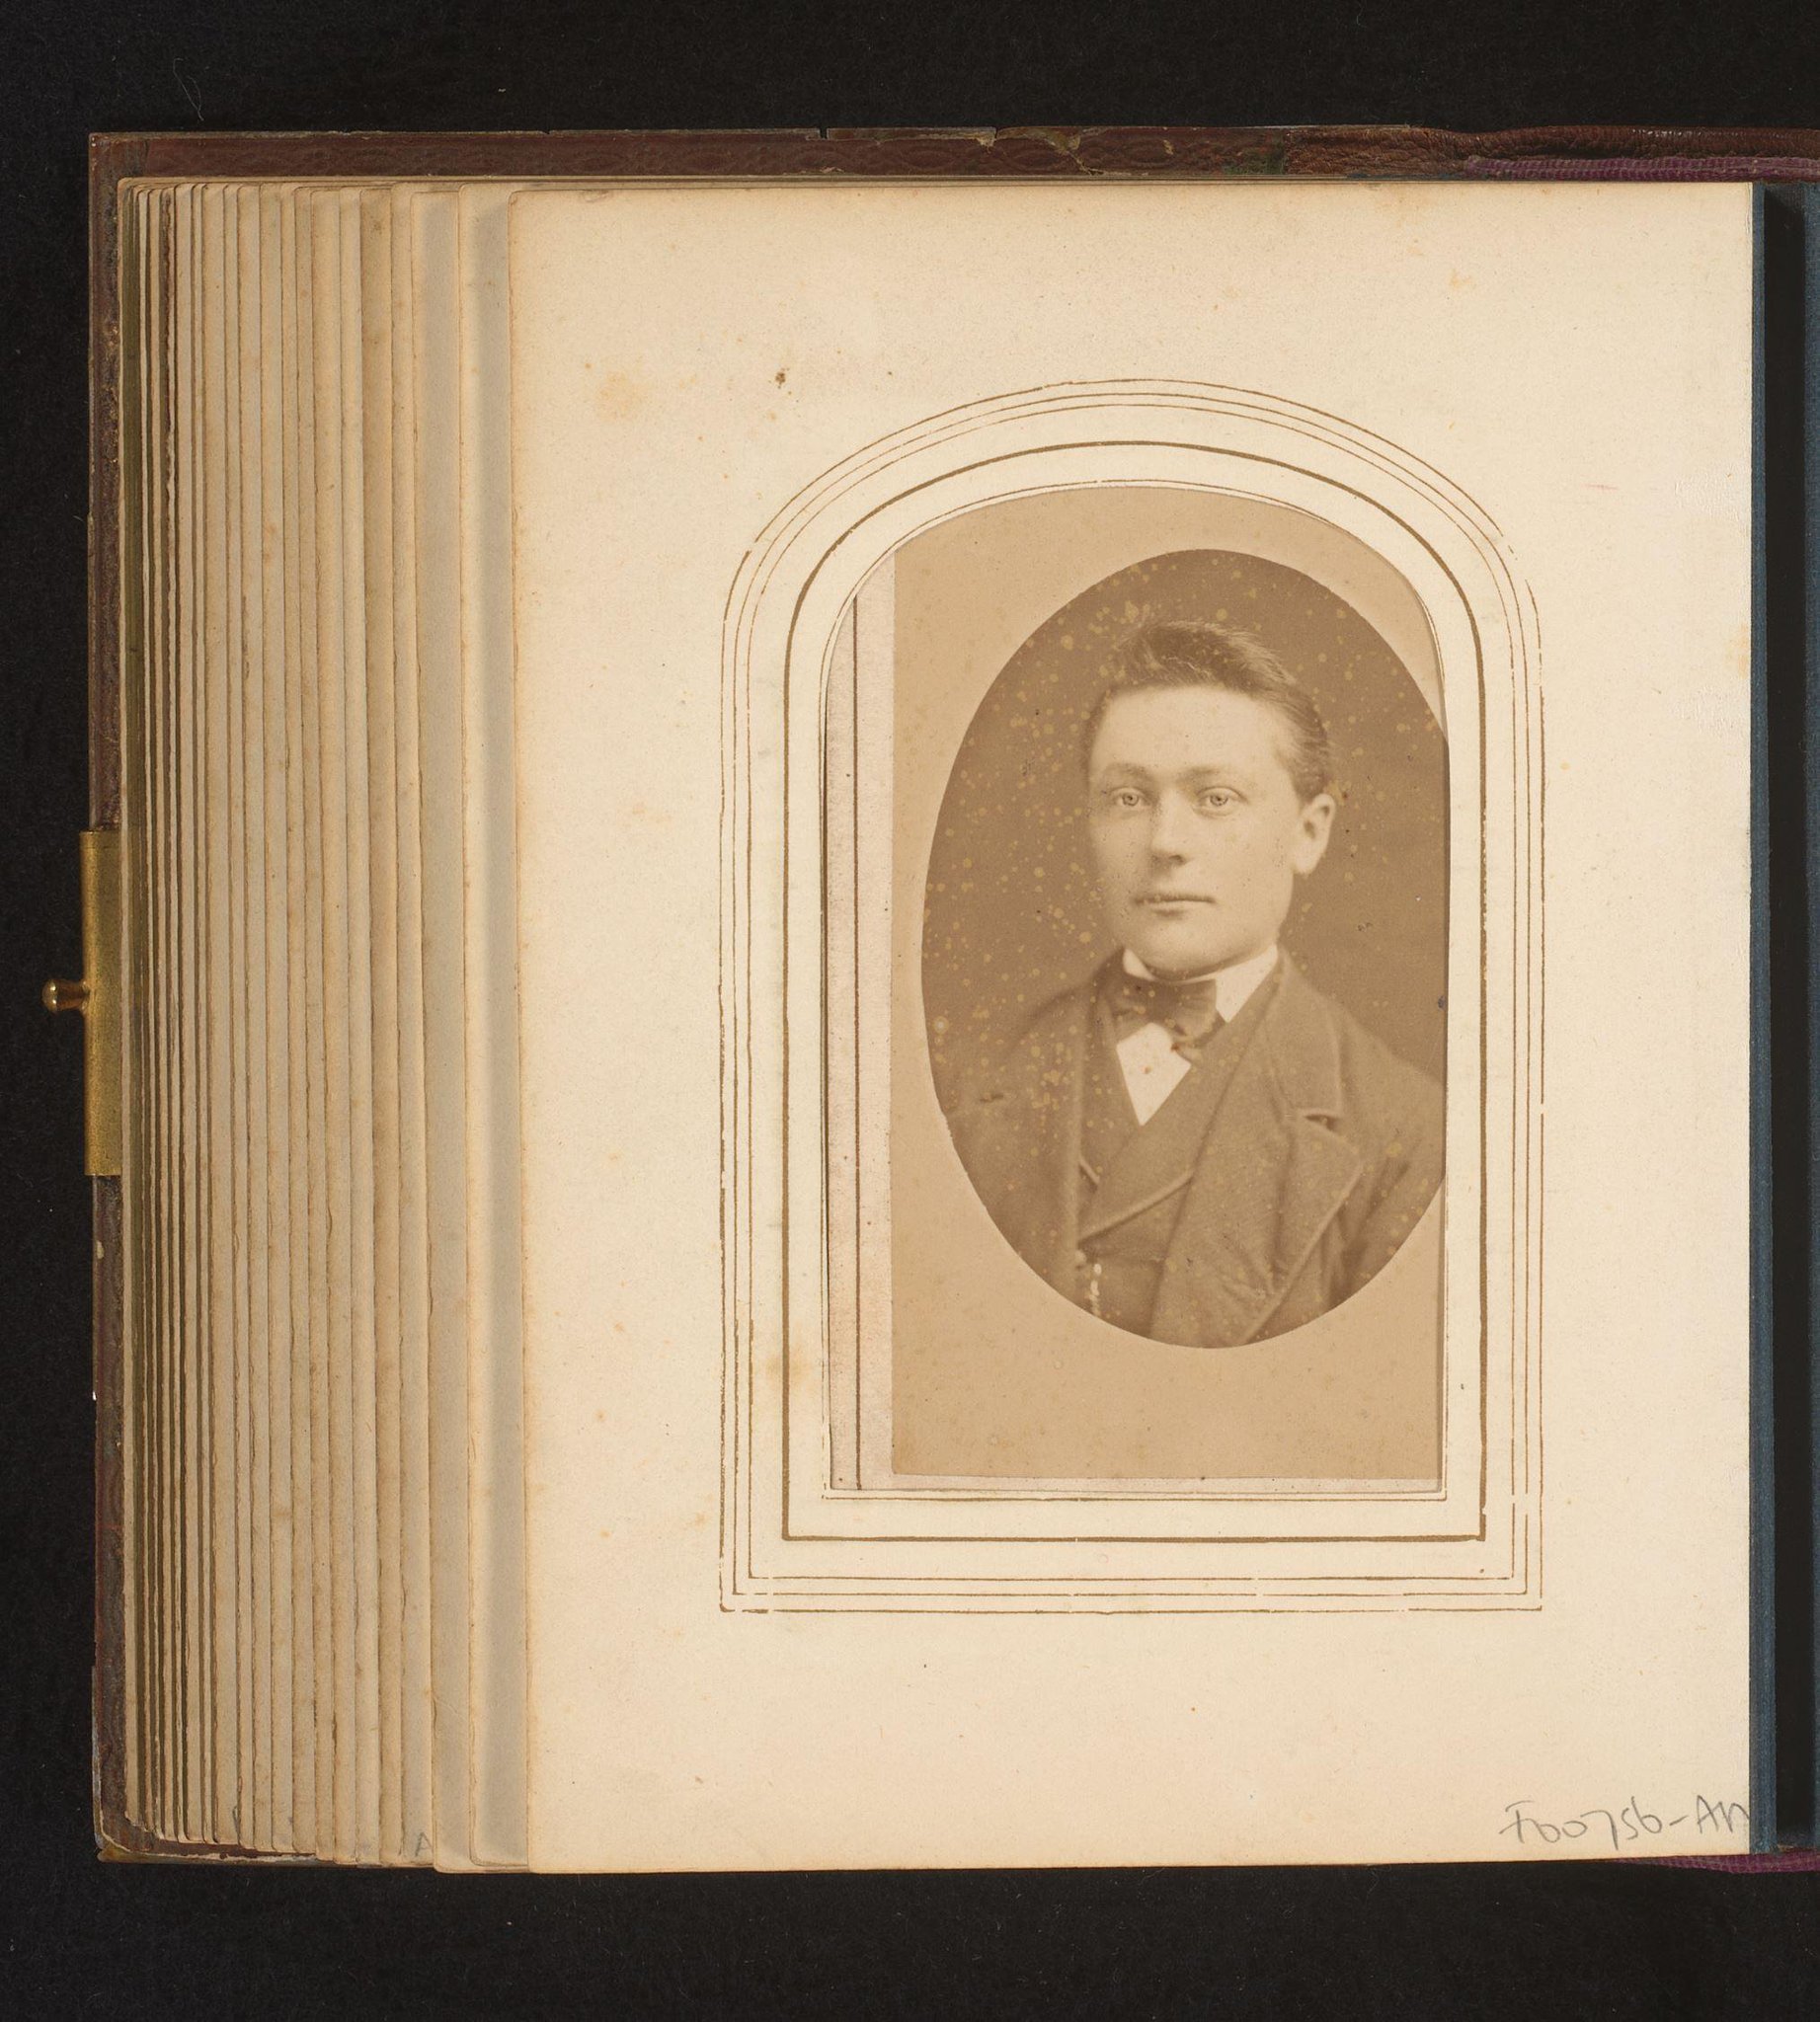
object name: carte de visite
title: Portret van een jonge man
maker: benjamin sanders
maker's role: fotograaf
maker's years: 1841-1889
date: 1856-1889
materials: cardboard, photographic support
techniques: albumen print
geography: groningen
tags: historical persons, youth, adolescent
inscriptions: inscription: ‘Benjamin Sanders/ PHOTOGRAPHISCH ATELIER/ Heerestraat F.No.306./ GRONINGEN/ De plaat blijft voor nabestelling bewaard.’